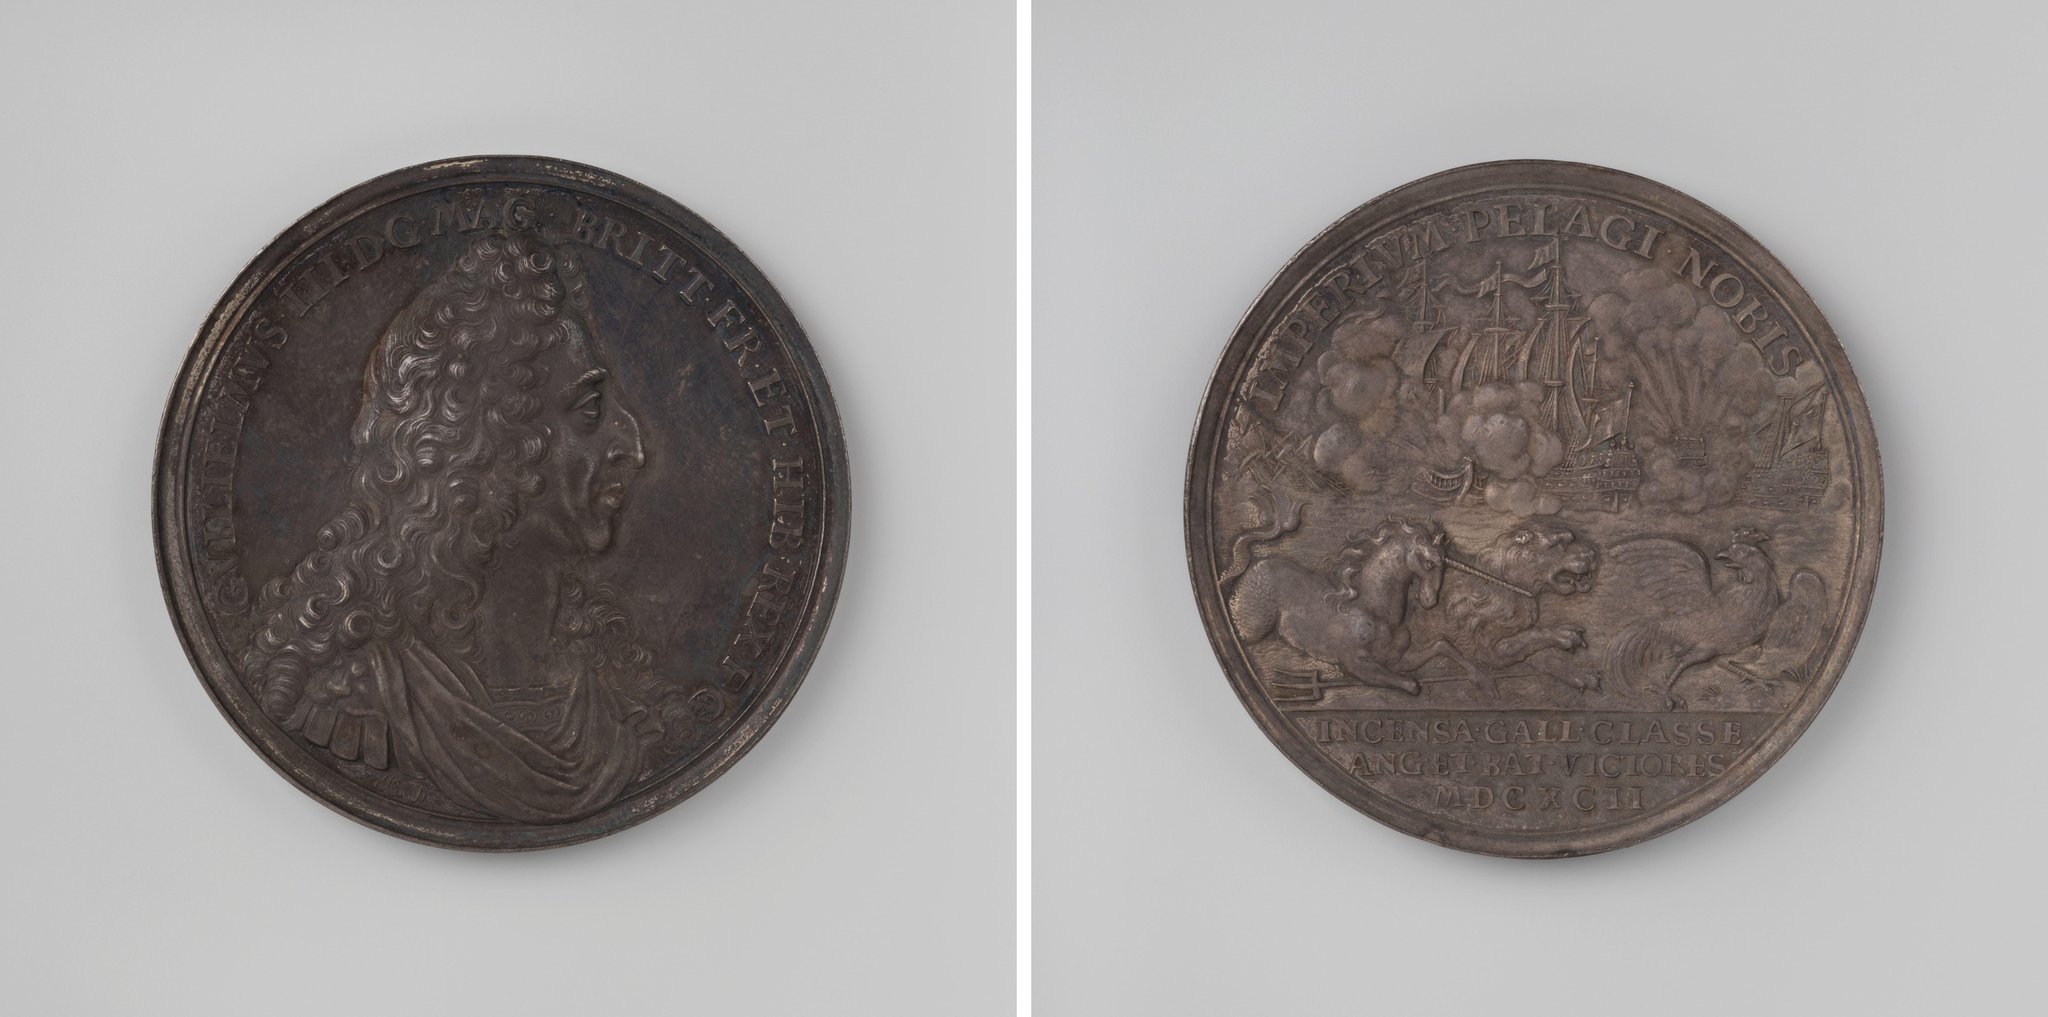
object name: history medal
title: Zeeslag bij Kaap La Hogue, de Fransen verslagen door de vloot van Engeland en Holland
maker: jan boskam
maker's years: 1687-1708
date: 1692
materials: silver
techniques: striking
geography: nijmegen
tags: the hague, william iii (prince of orange and king of england, scotland, and ireland)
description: Zilveren penning. Voorzijde: borststuk man binnen omschrift. Keerzijde: zeeslag met een zinkend Frans schip en een schip dat in de lucht vliegt op de voorgrond vlucht de Franse haan voor een leeuw en een eenhoorn die de drietand grijpen binnen omschrift; afsnede: opschrift